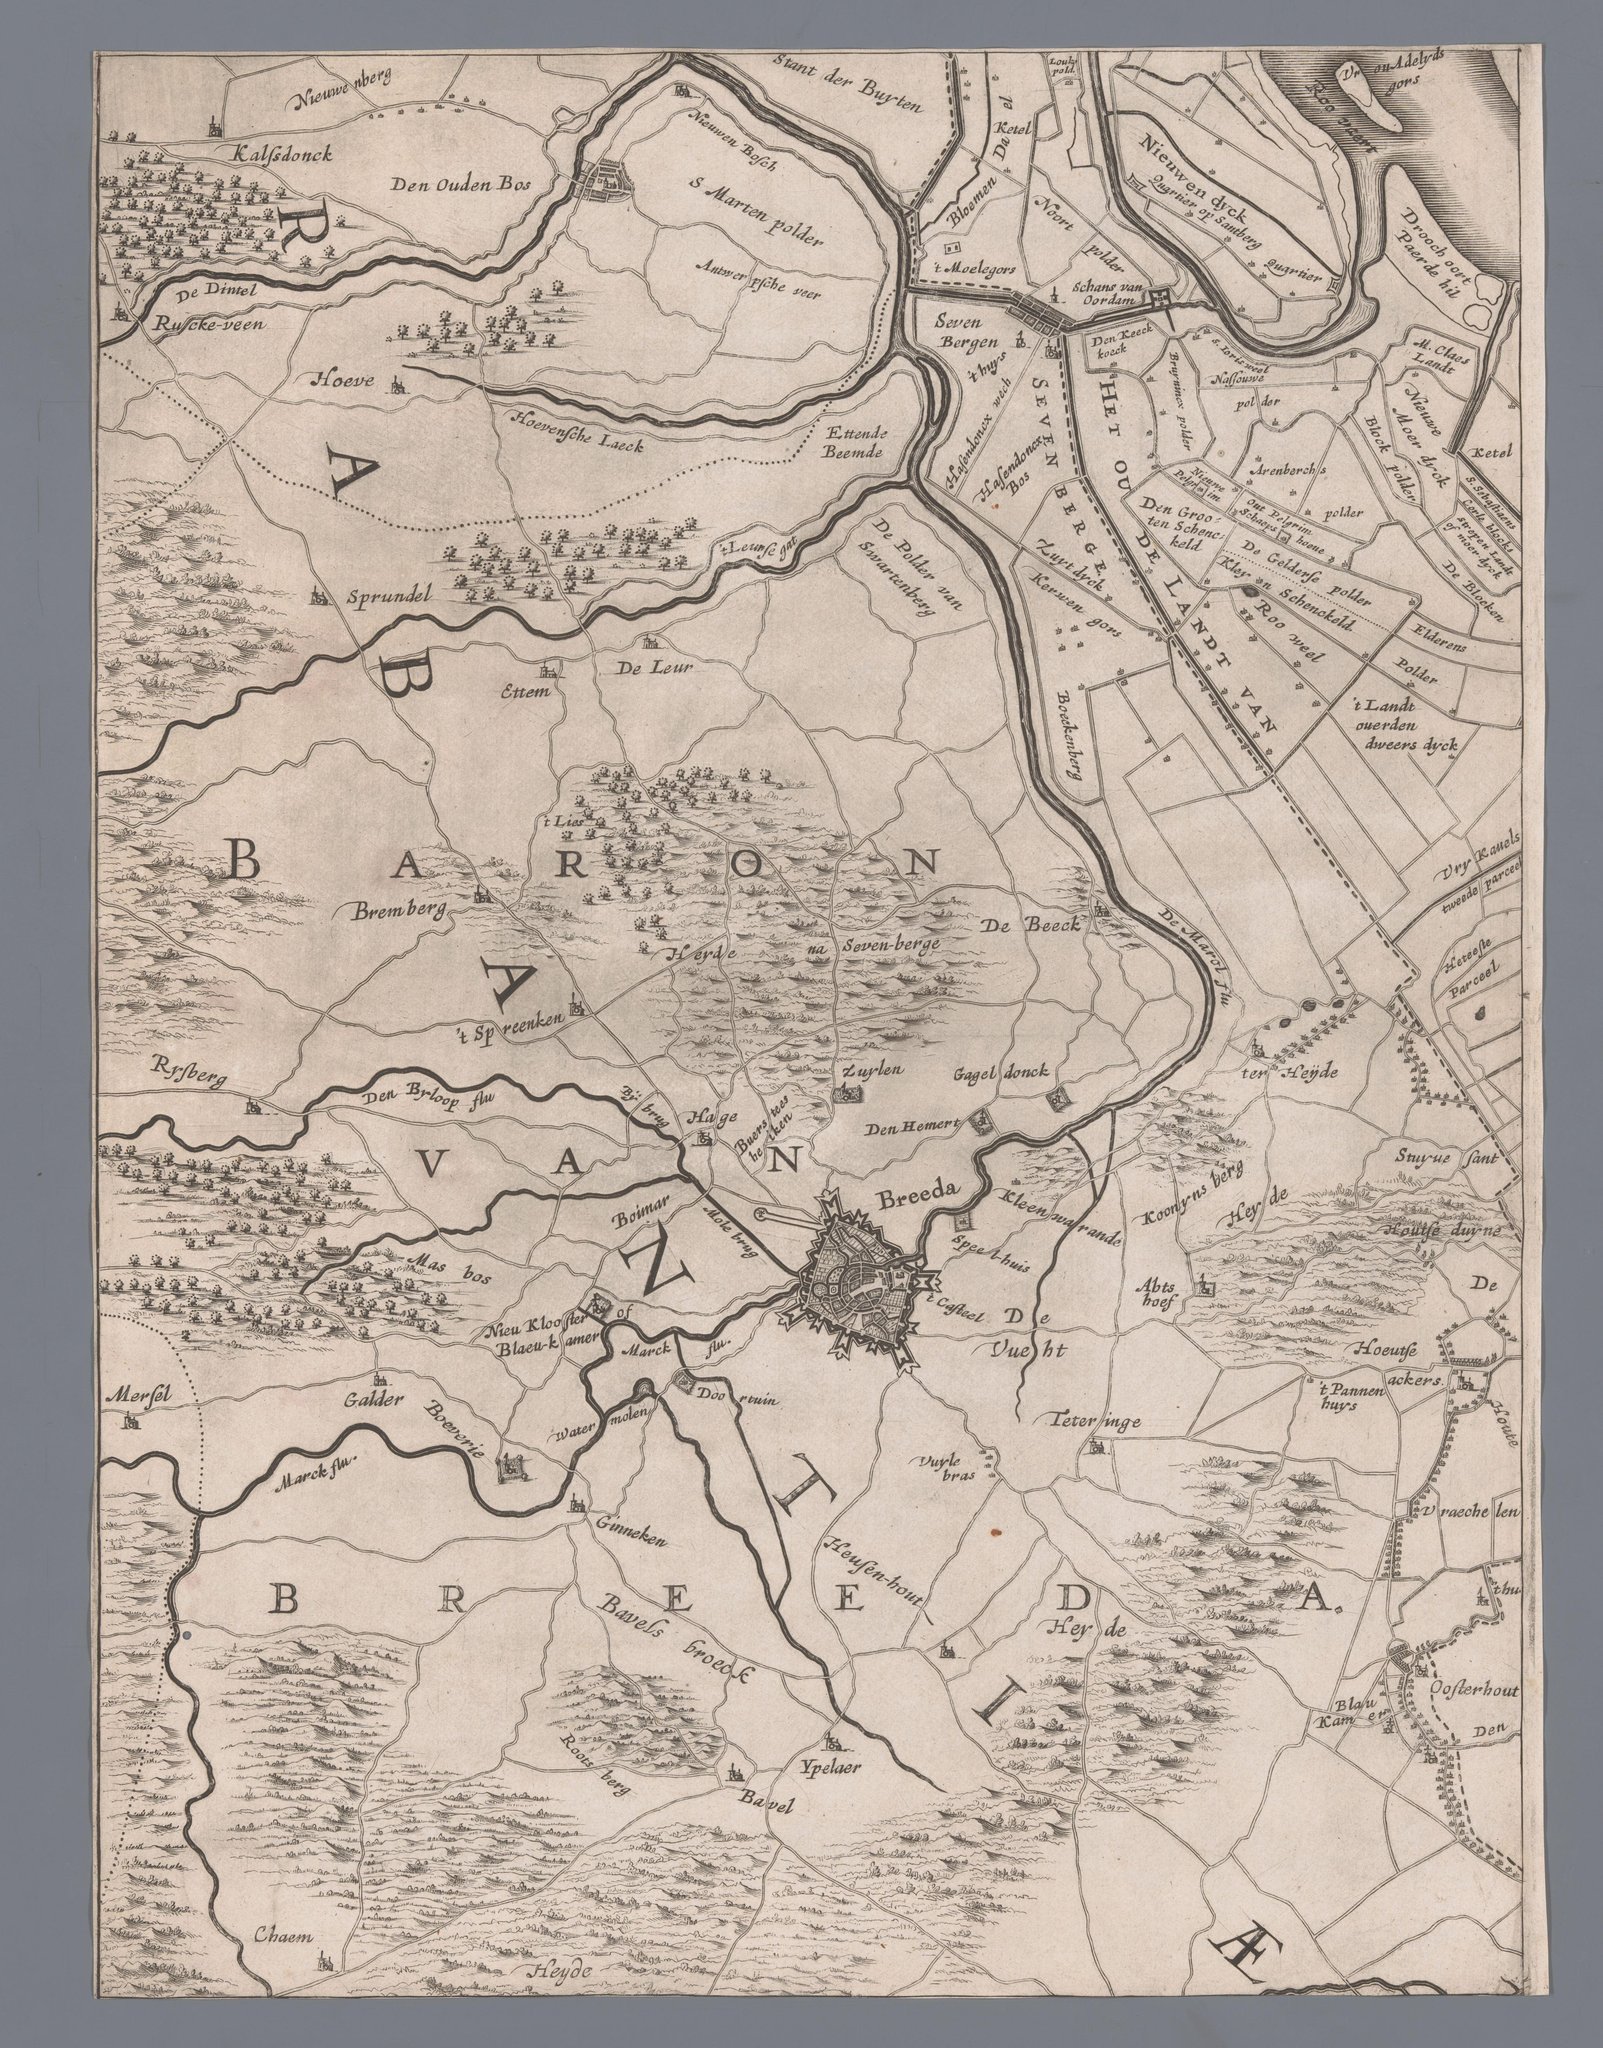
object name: map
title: Kaart van het Graafschap Holland en Utrecht (plaat 30)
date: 1639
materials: paper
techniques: engraving, etching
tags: maps, atlases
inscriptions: collector's mark: Lugt 2228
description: Onderdeel van een kaart samengesteld uit 40 bladen. Waarschijnlijk gaat het om de grootste kaart van Holland uit de zeventiende-eeuw. De kaart is uitgegeven in verschillende edities, deze kaart uit 1639 is de eerste editie.